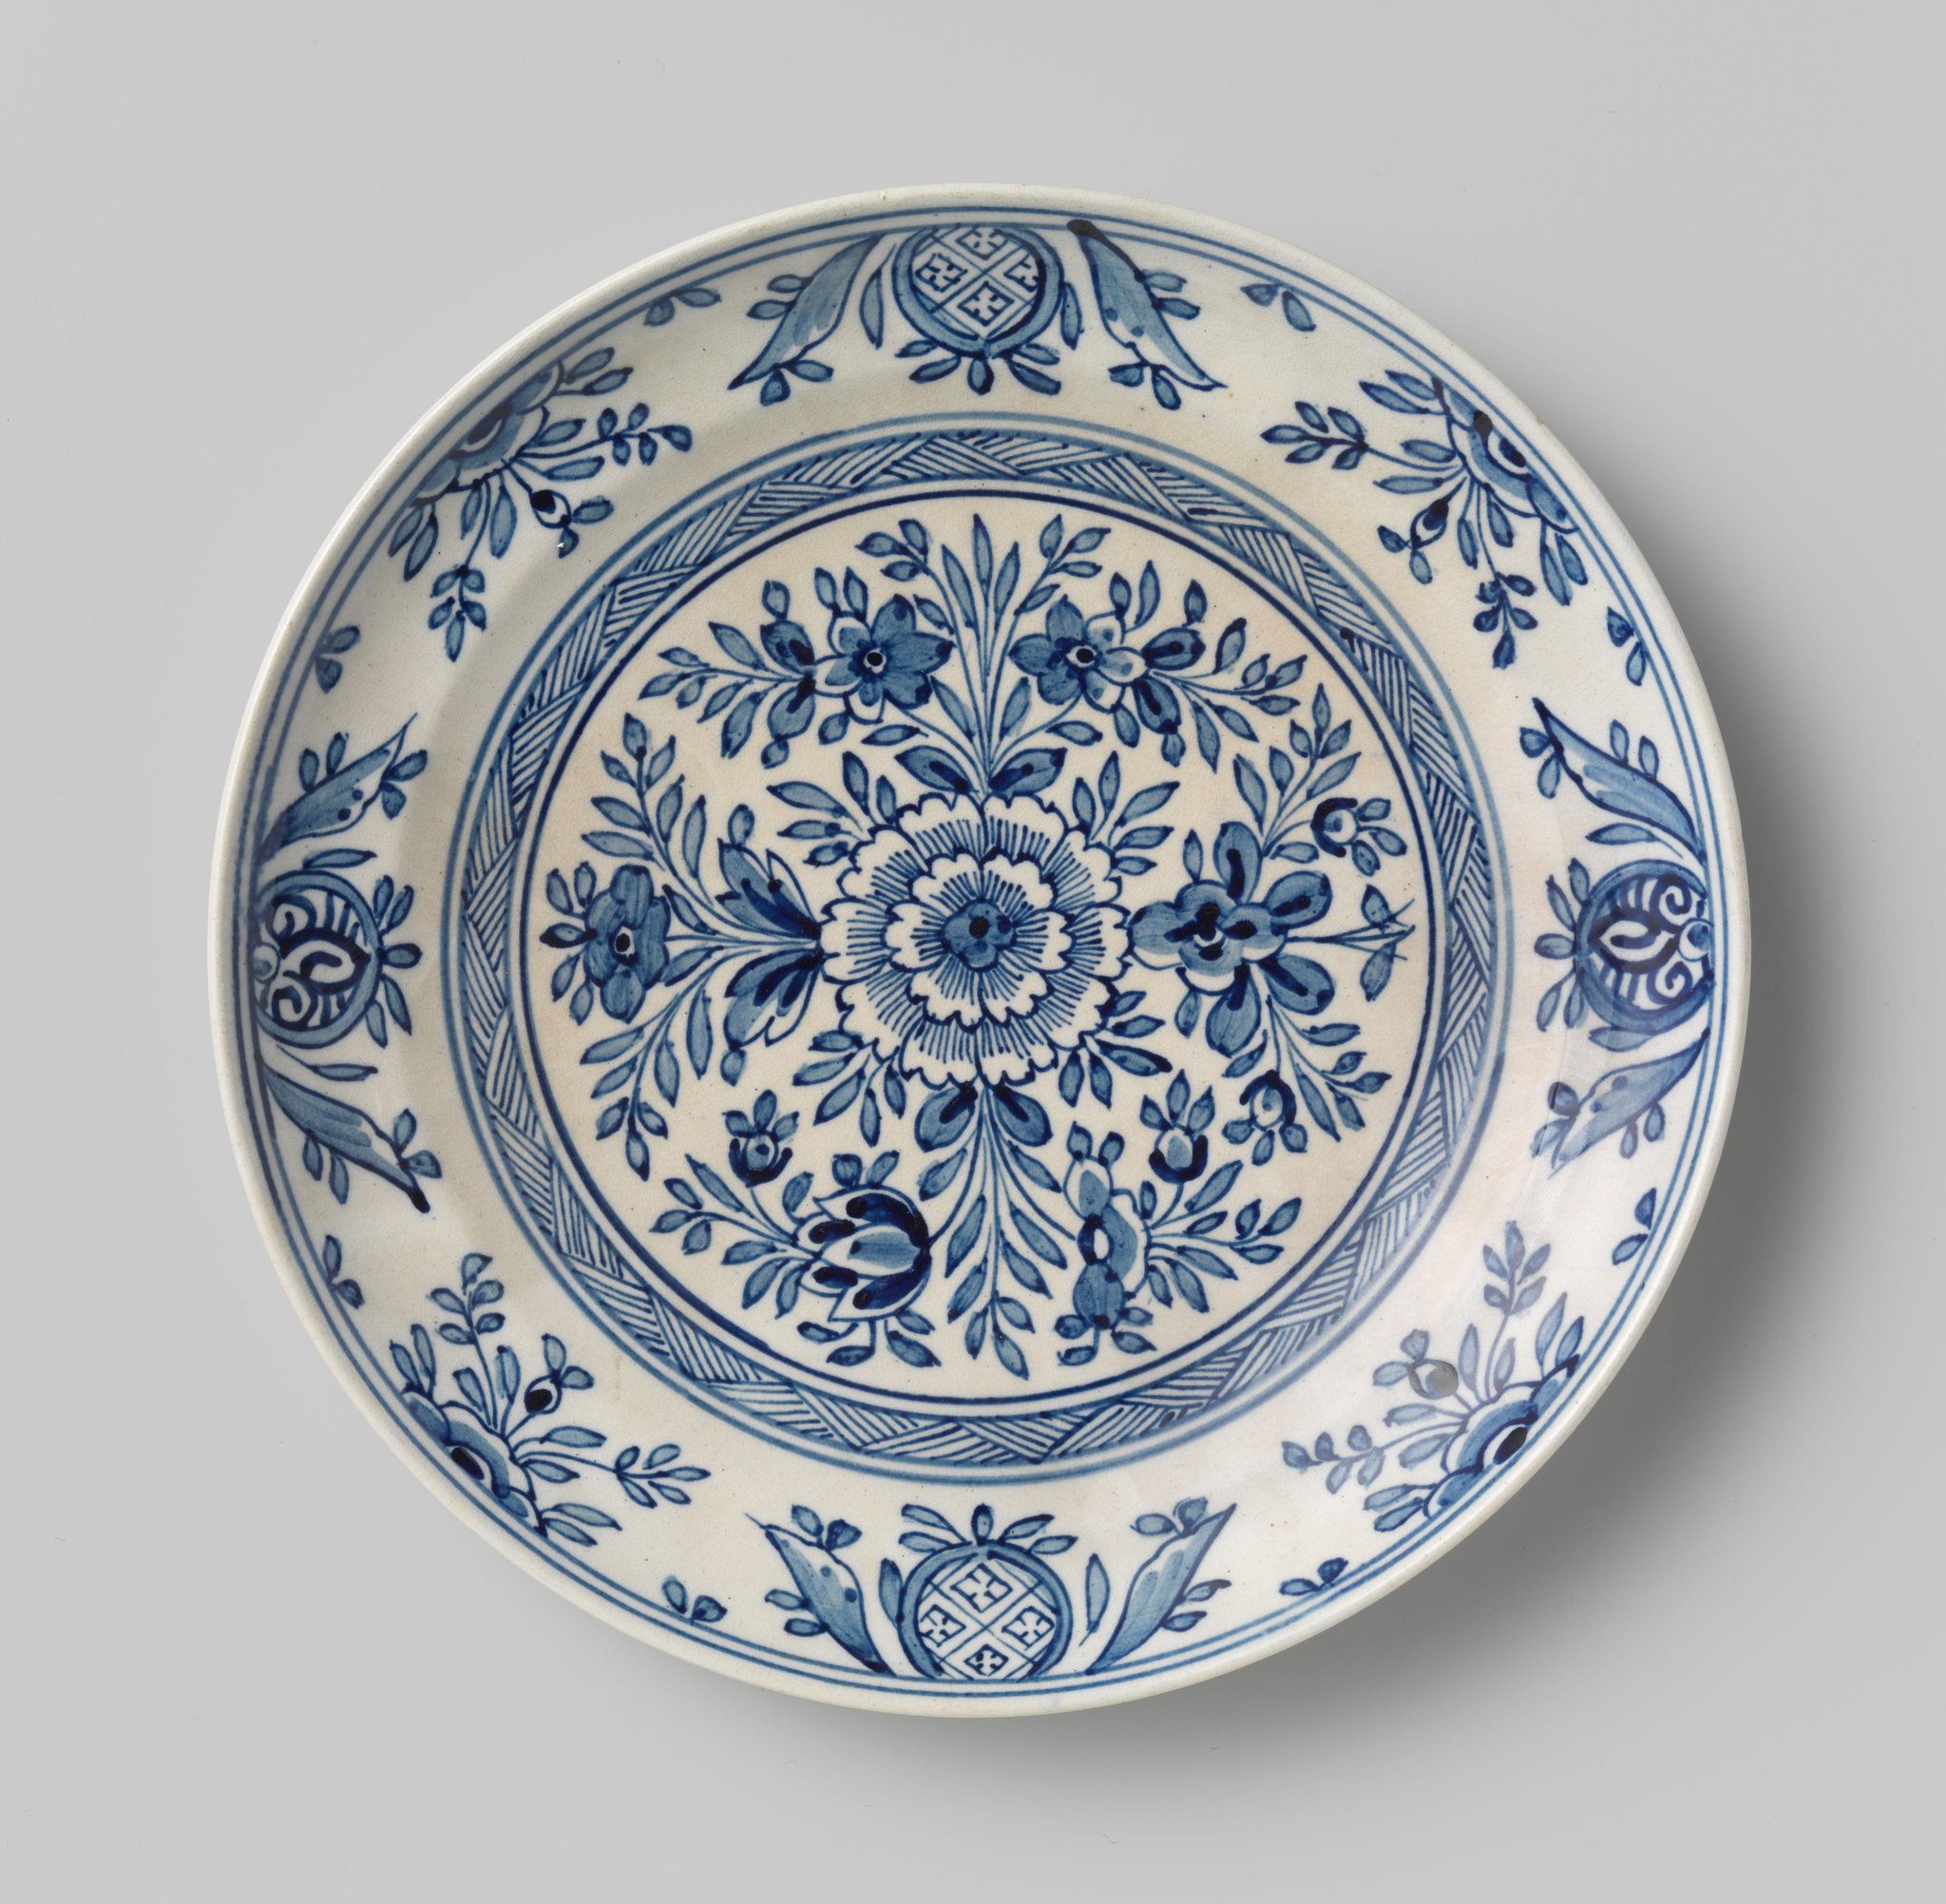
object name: plate dish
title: Bord, beschilderd met bloemen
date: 1880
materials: earthenware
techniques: painted, vitrification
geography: delft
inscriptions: mark: ‘fles ; E. ; symbool. Delft’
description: Bord van aardewerk, deel van een servies. Beschilderd in onderglazuur blauw met bloemmotieven. Gemerkt.